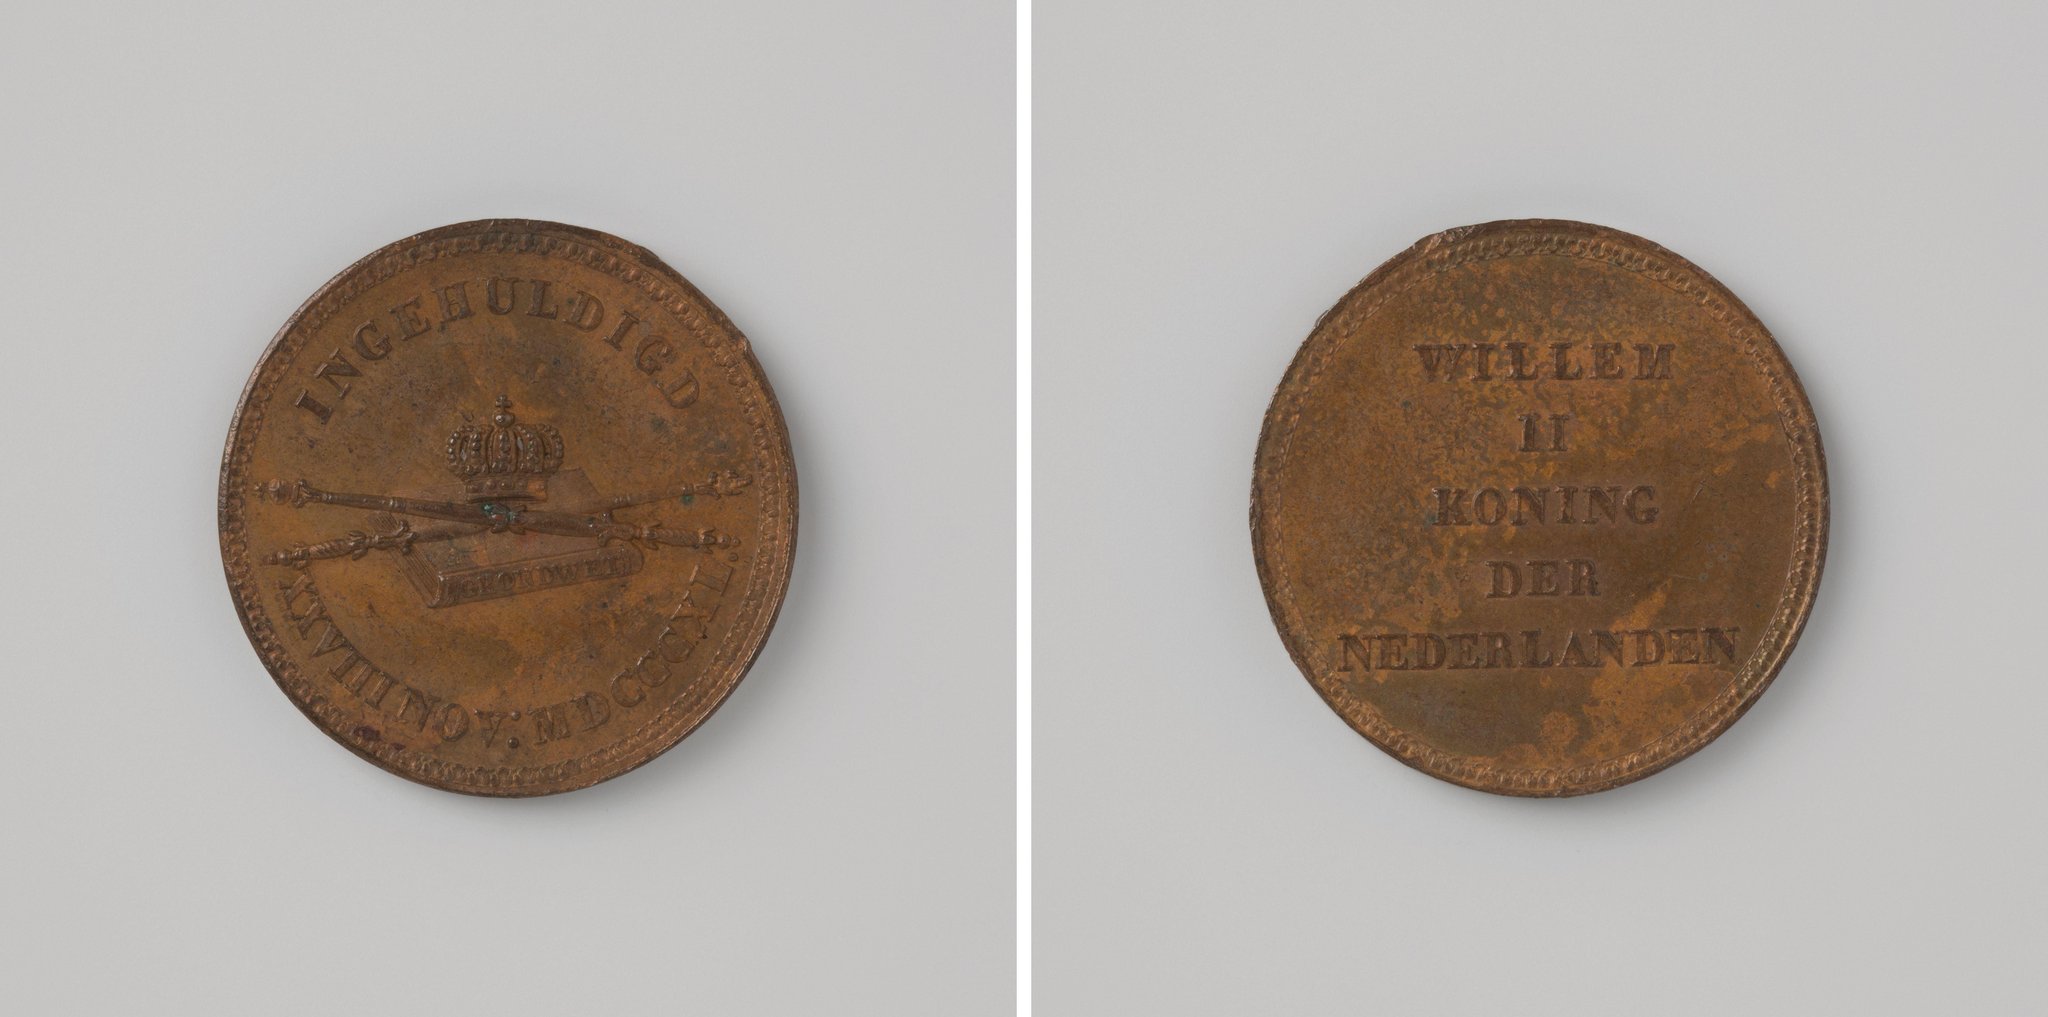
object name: history medal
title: Strooipenning bij de inhuldiging van Koning Willem II te Amsterdam 1840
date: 1840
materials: bronze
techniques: striking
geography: utrecht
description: Bronzen penning, op de voorzijde de grondwet waarop kroon en scepter, met omschrift, op de keerzijde vier regels tekst.